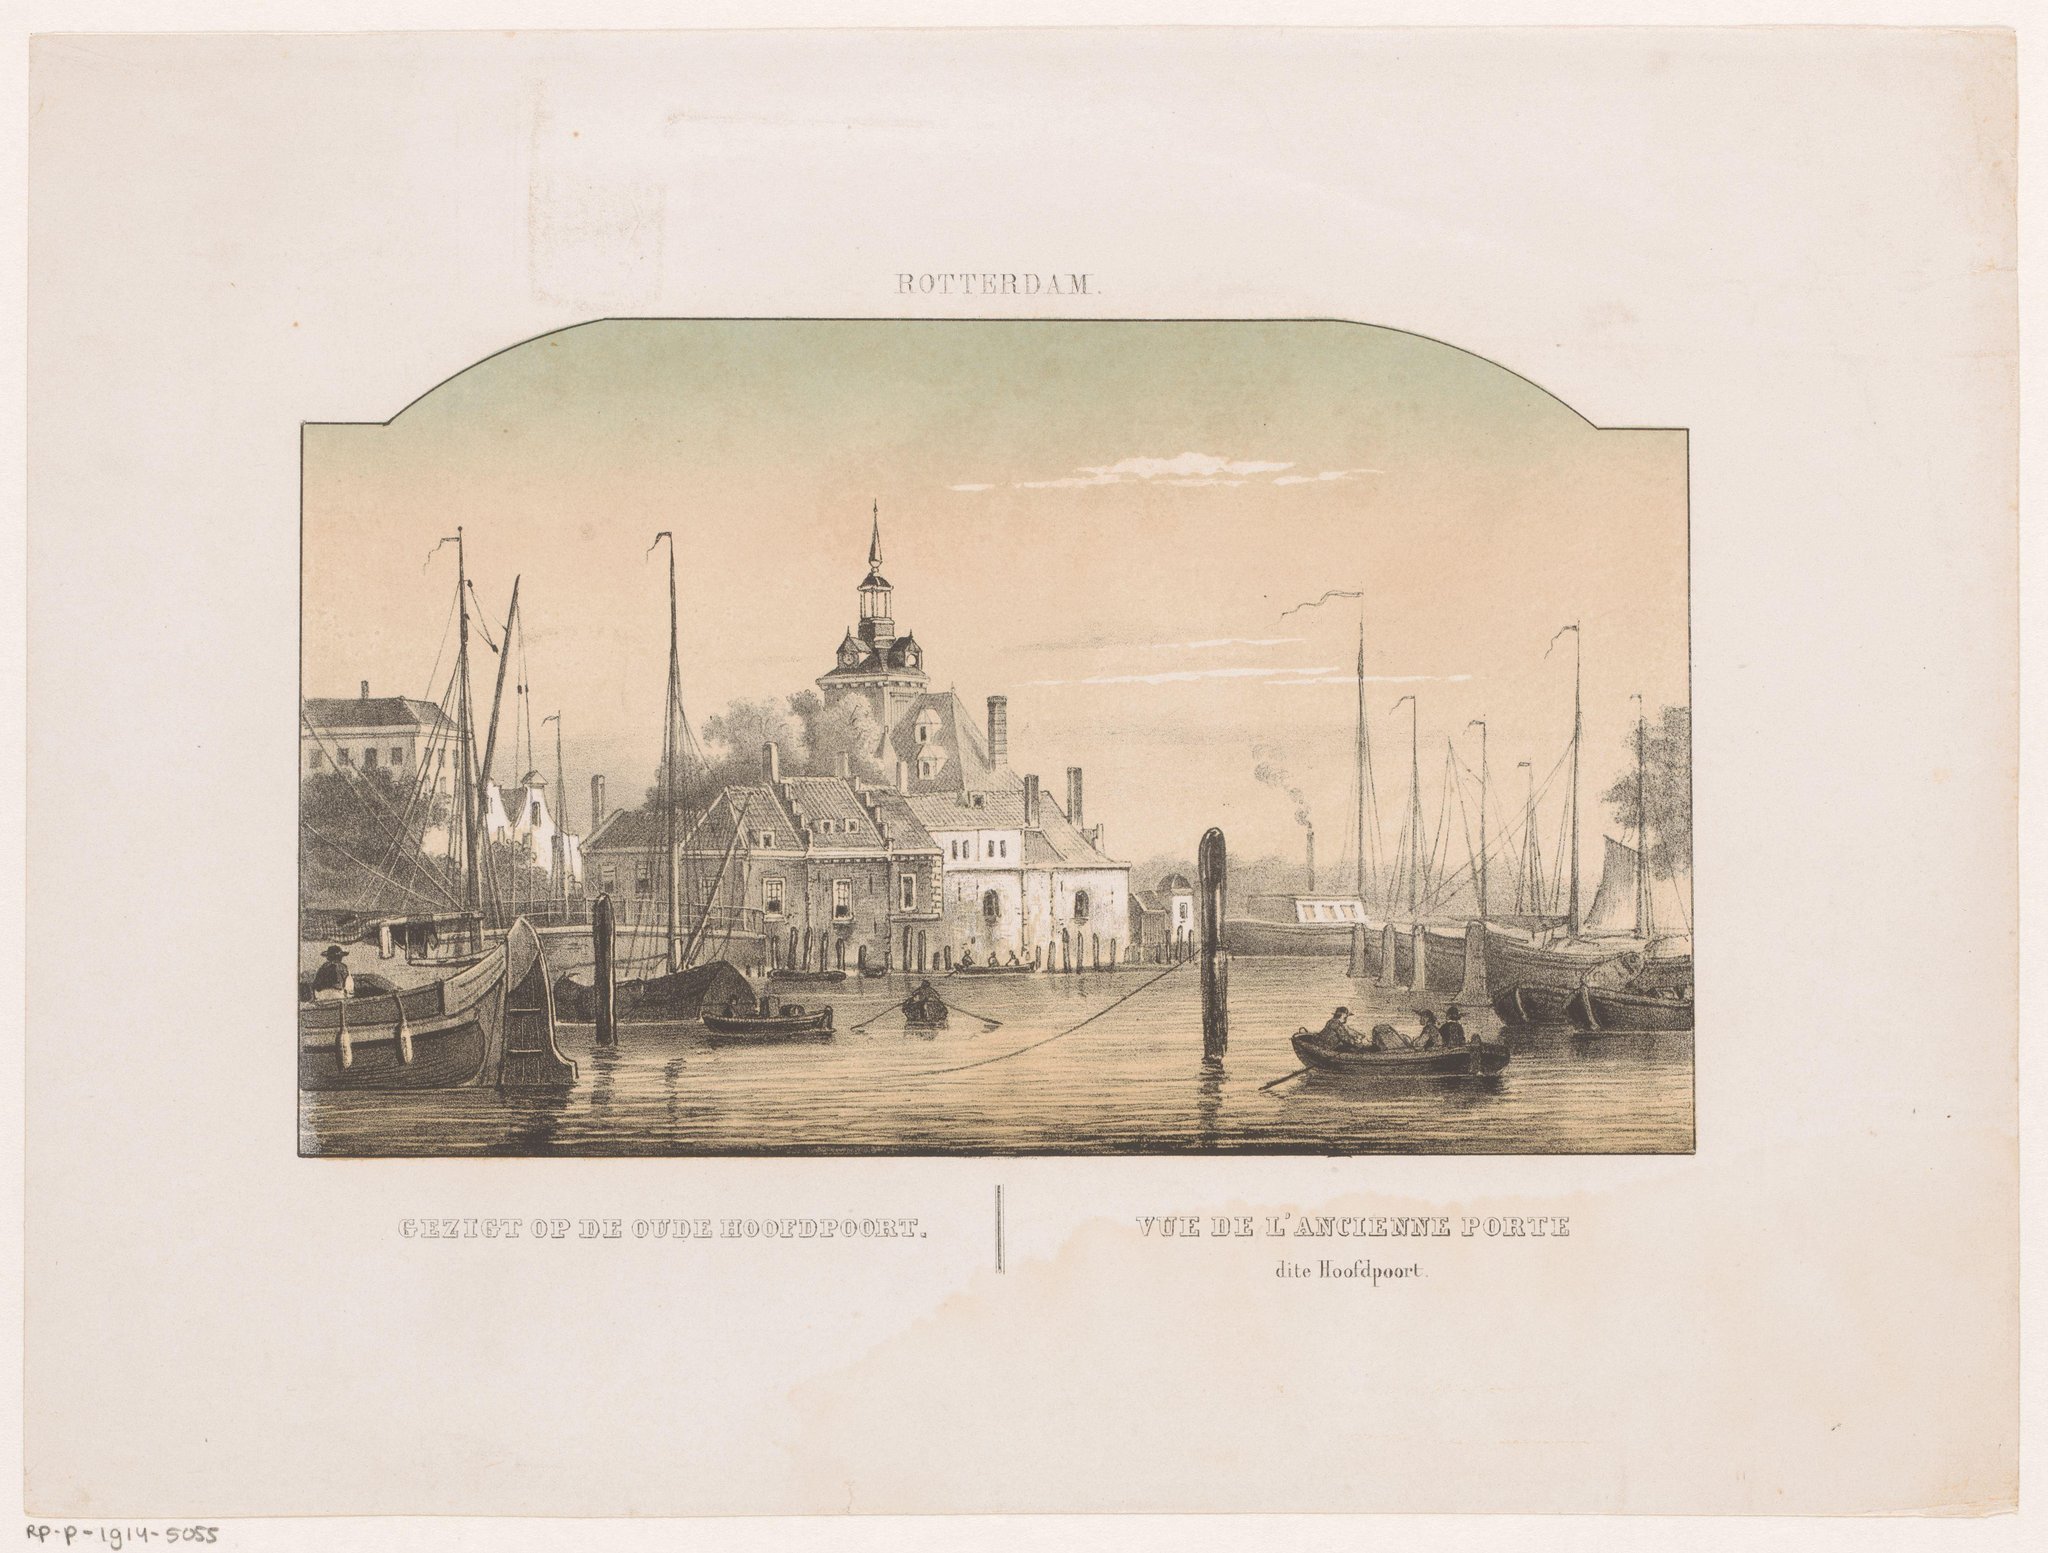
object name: print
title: Rotterdam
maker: hendrik wilhelmus last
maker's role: print maker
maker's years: 1817-1873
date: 1827-1873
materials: paper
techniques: iris print, lithograph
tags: river, city-gate (+ city(-scape) with figures, staffage), rotterdam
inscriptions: collector's mark: Lugt 2228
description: De poort is gezien vanaf het water van de Maas.